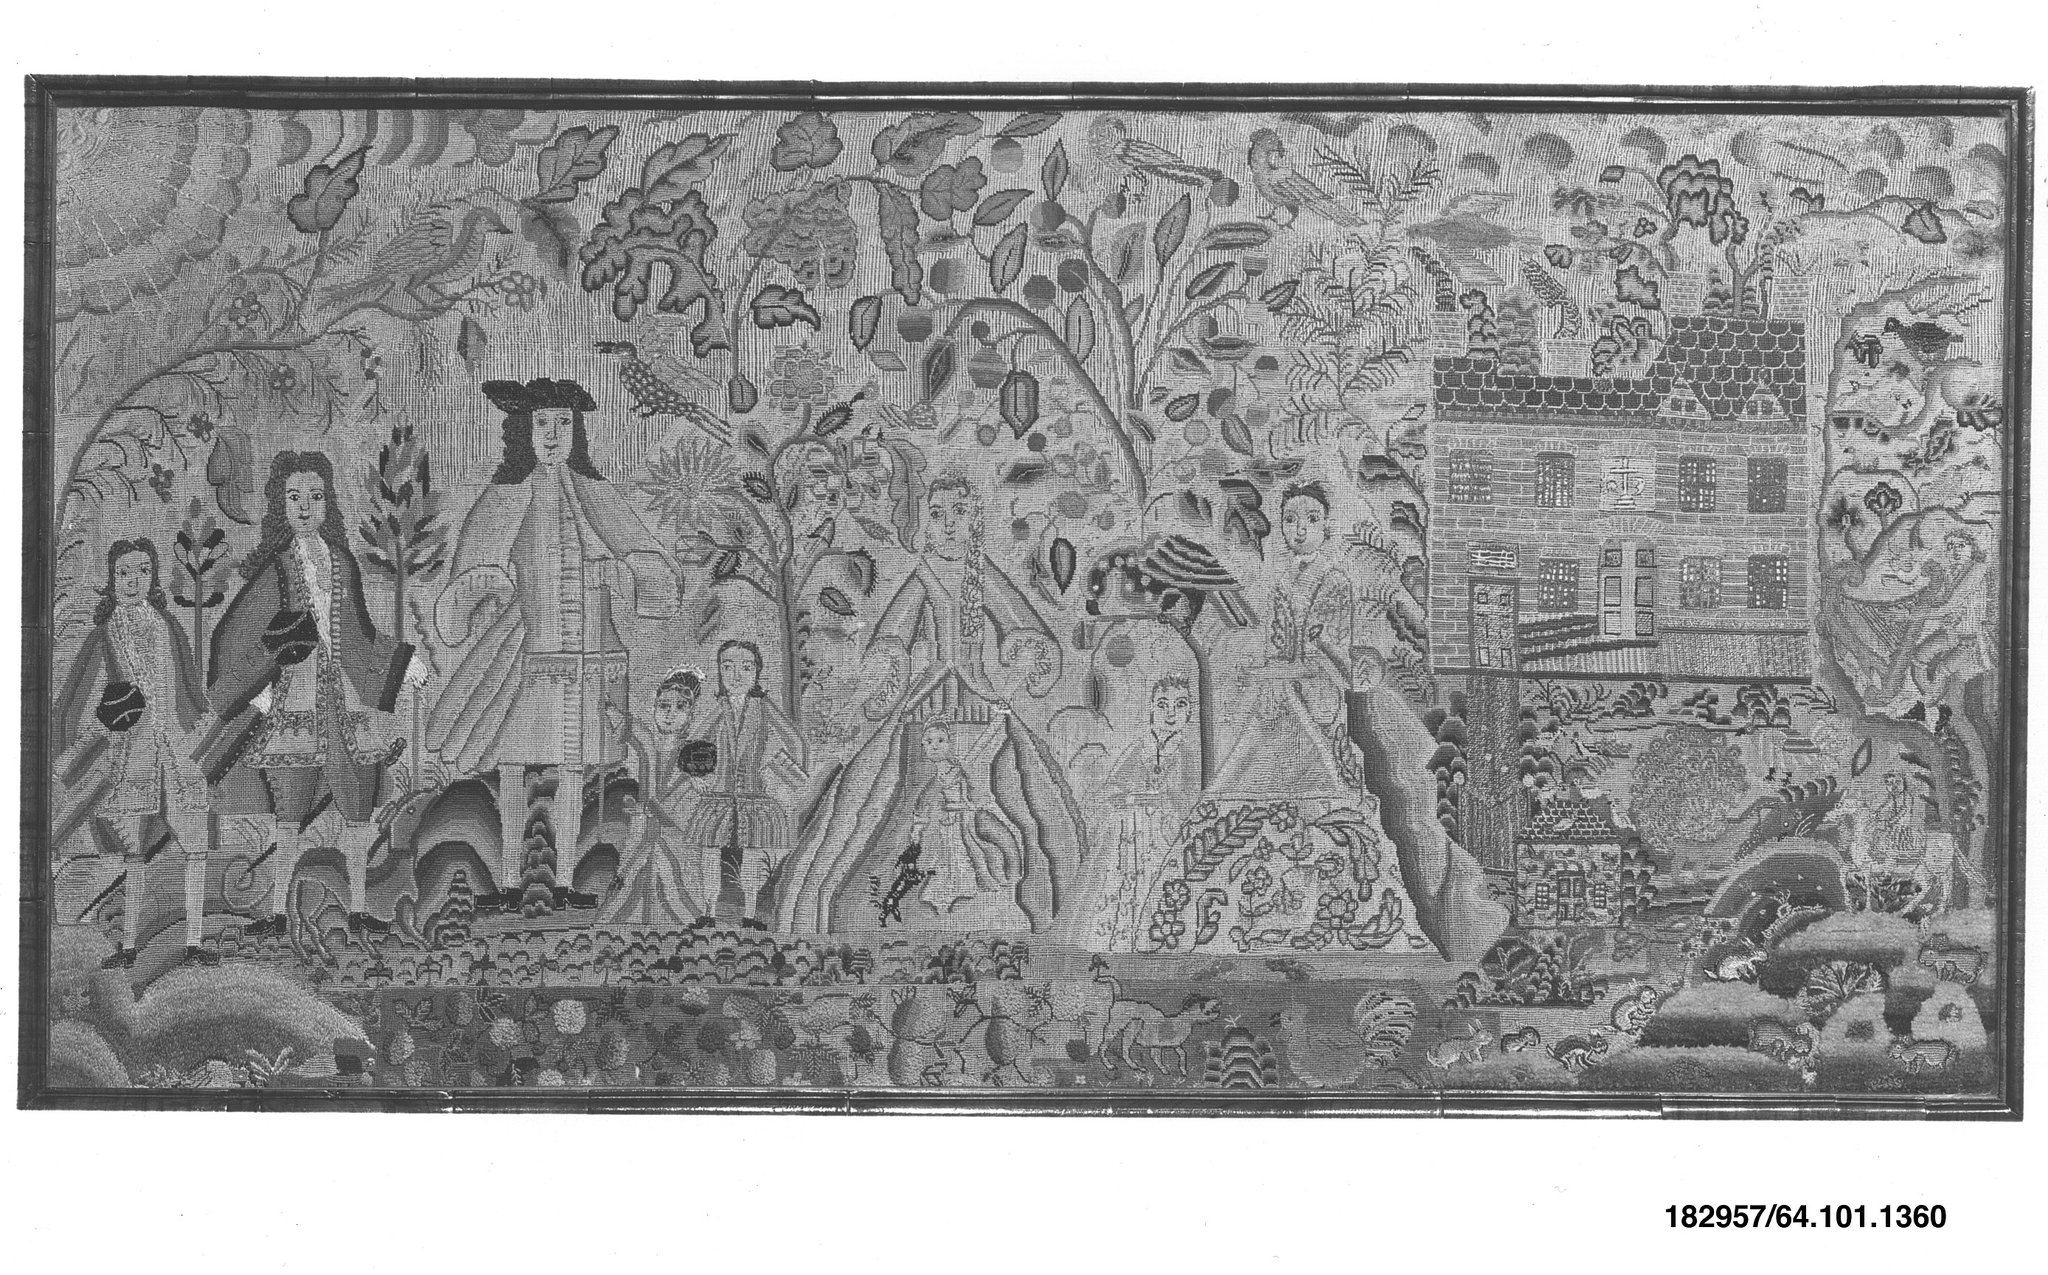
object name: embroidered picture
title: Embroidered picture with a family in a garden setting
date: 1701-1725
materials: canvas, metal thread, silk, wool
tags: birds,houses,gardens,trees,family